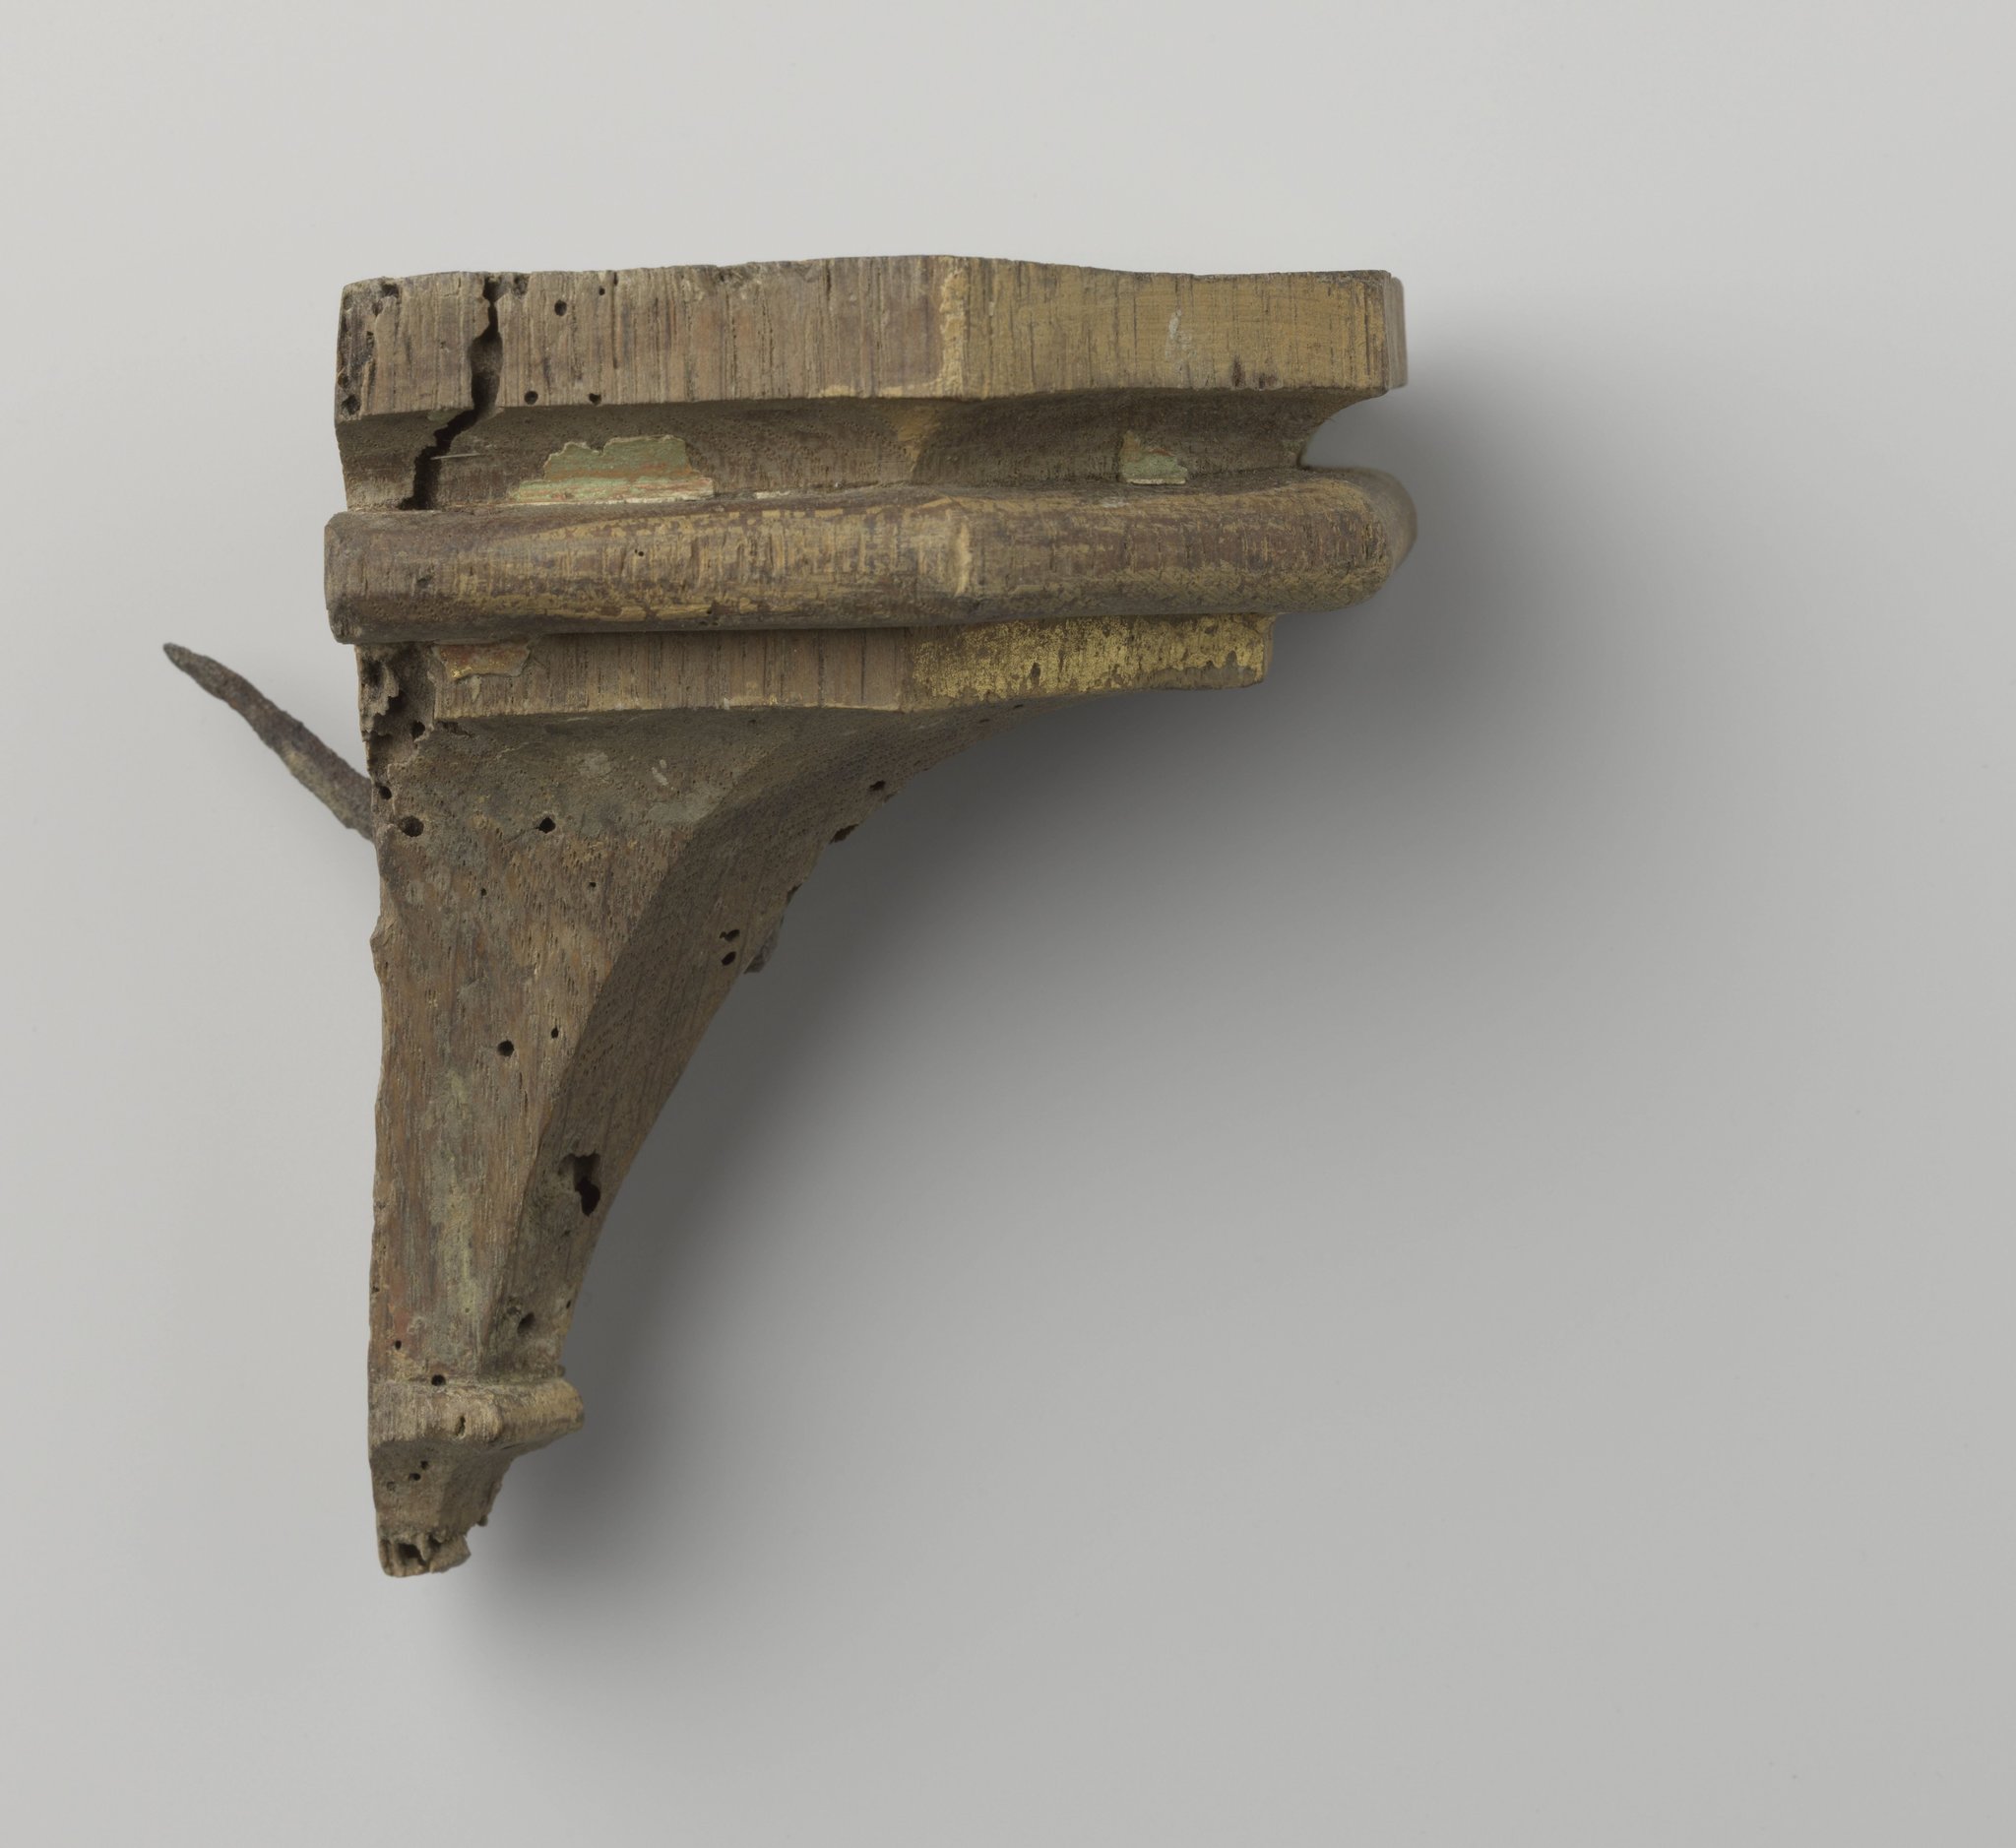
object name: fragment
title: Fragment (console van de altaarkast?); (mogelijk) behorend tot het retabel van Soest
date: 1475-1499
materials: wood